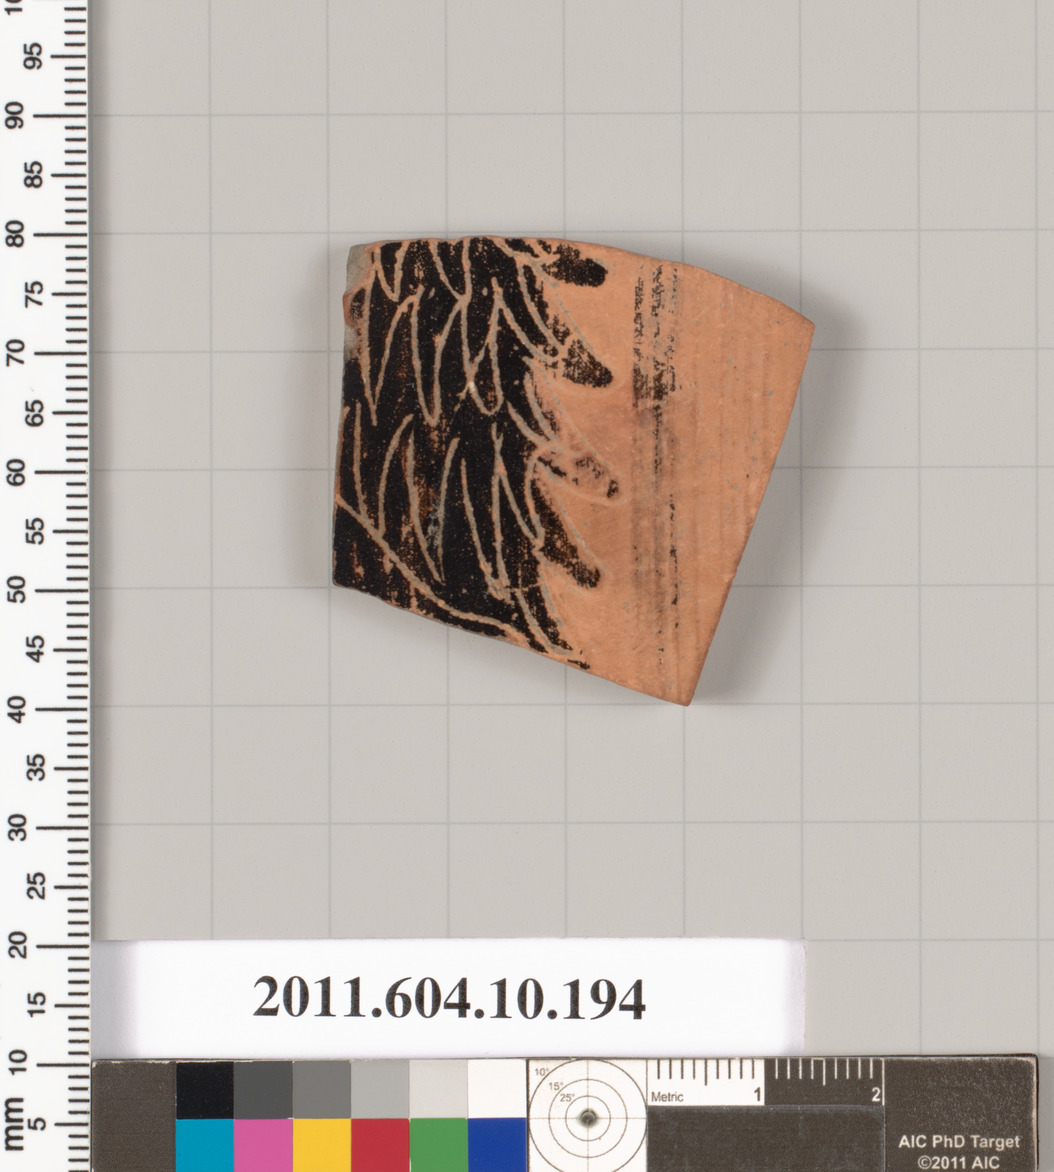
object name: undetermined closed shape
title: Terracotta fragment from a closed shape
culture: etruscan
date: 600-501 BCE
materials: terracotta